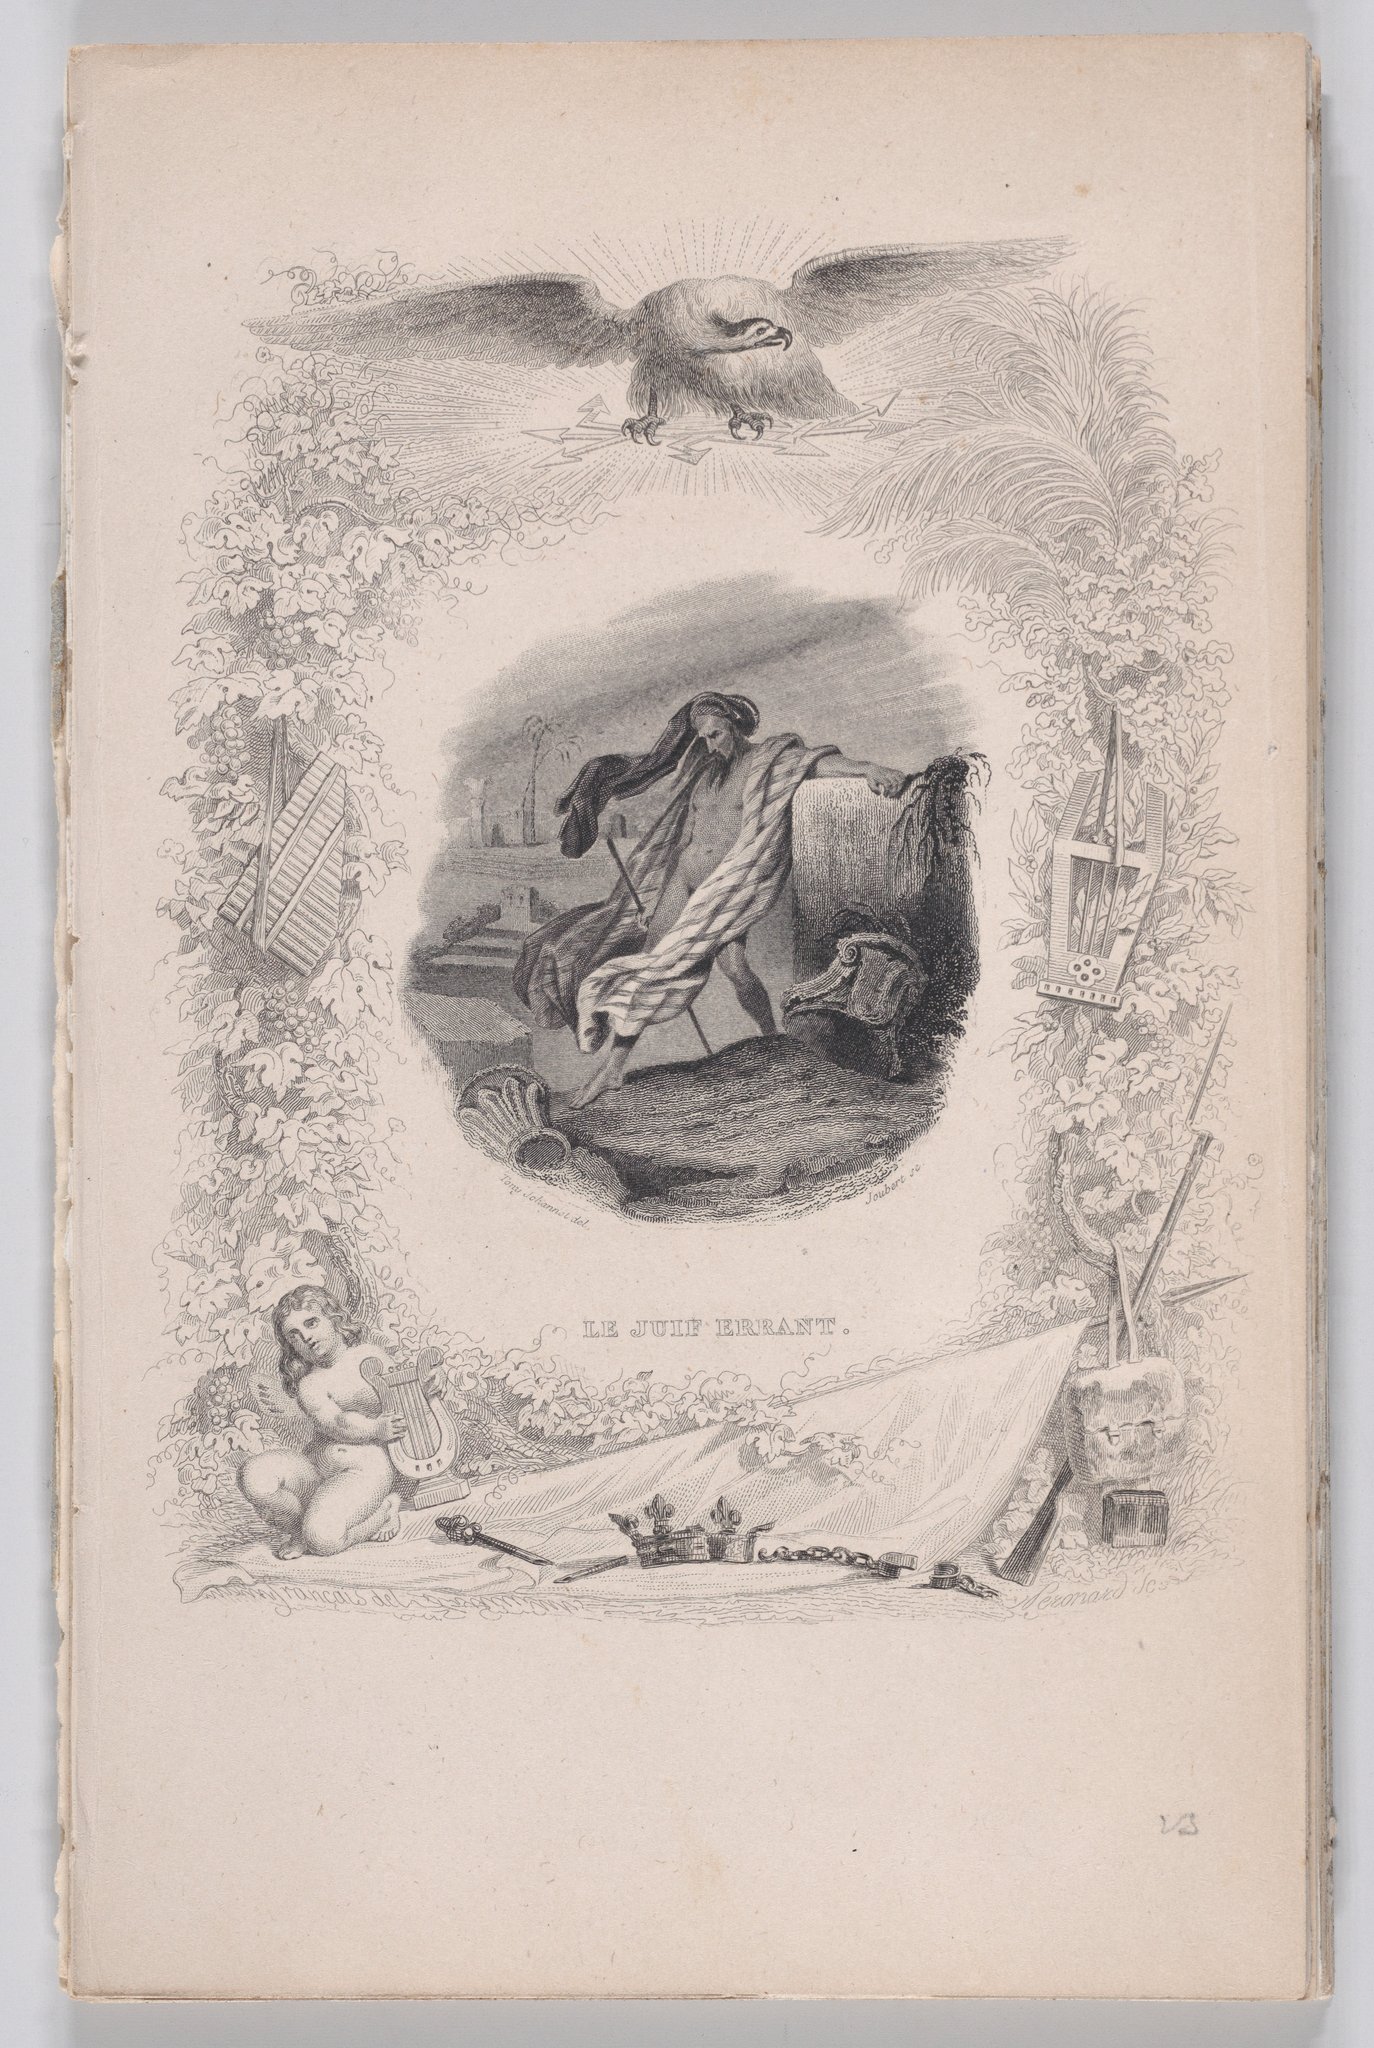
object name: print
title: The Wandering Jew, from "The Songs of Béranger"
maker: tony johannot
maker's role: designer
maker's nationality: french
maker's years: 1803-1852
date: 1829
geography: paris